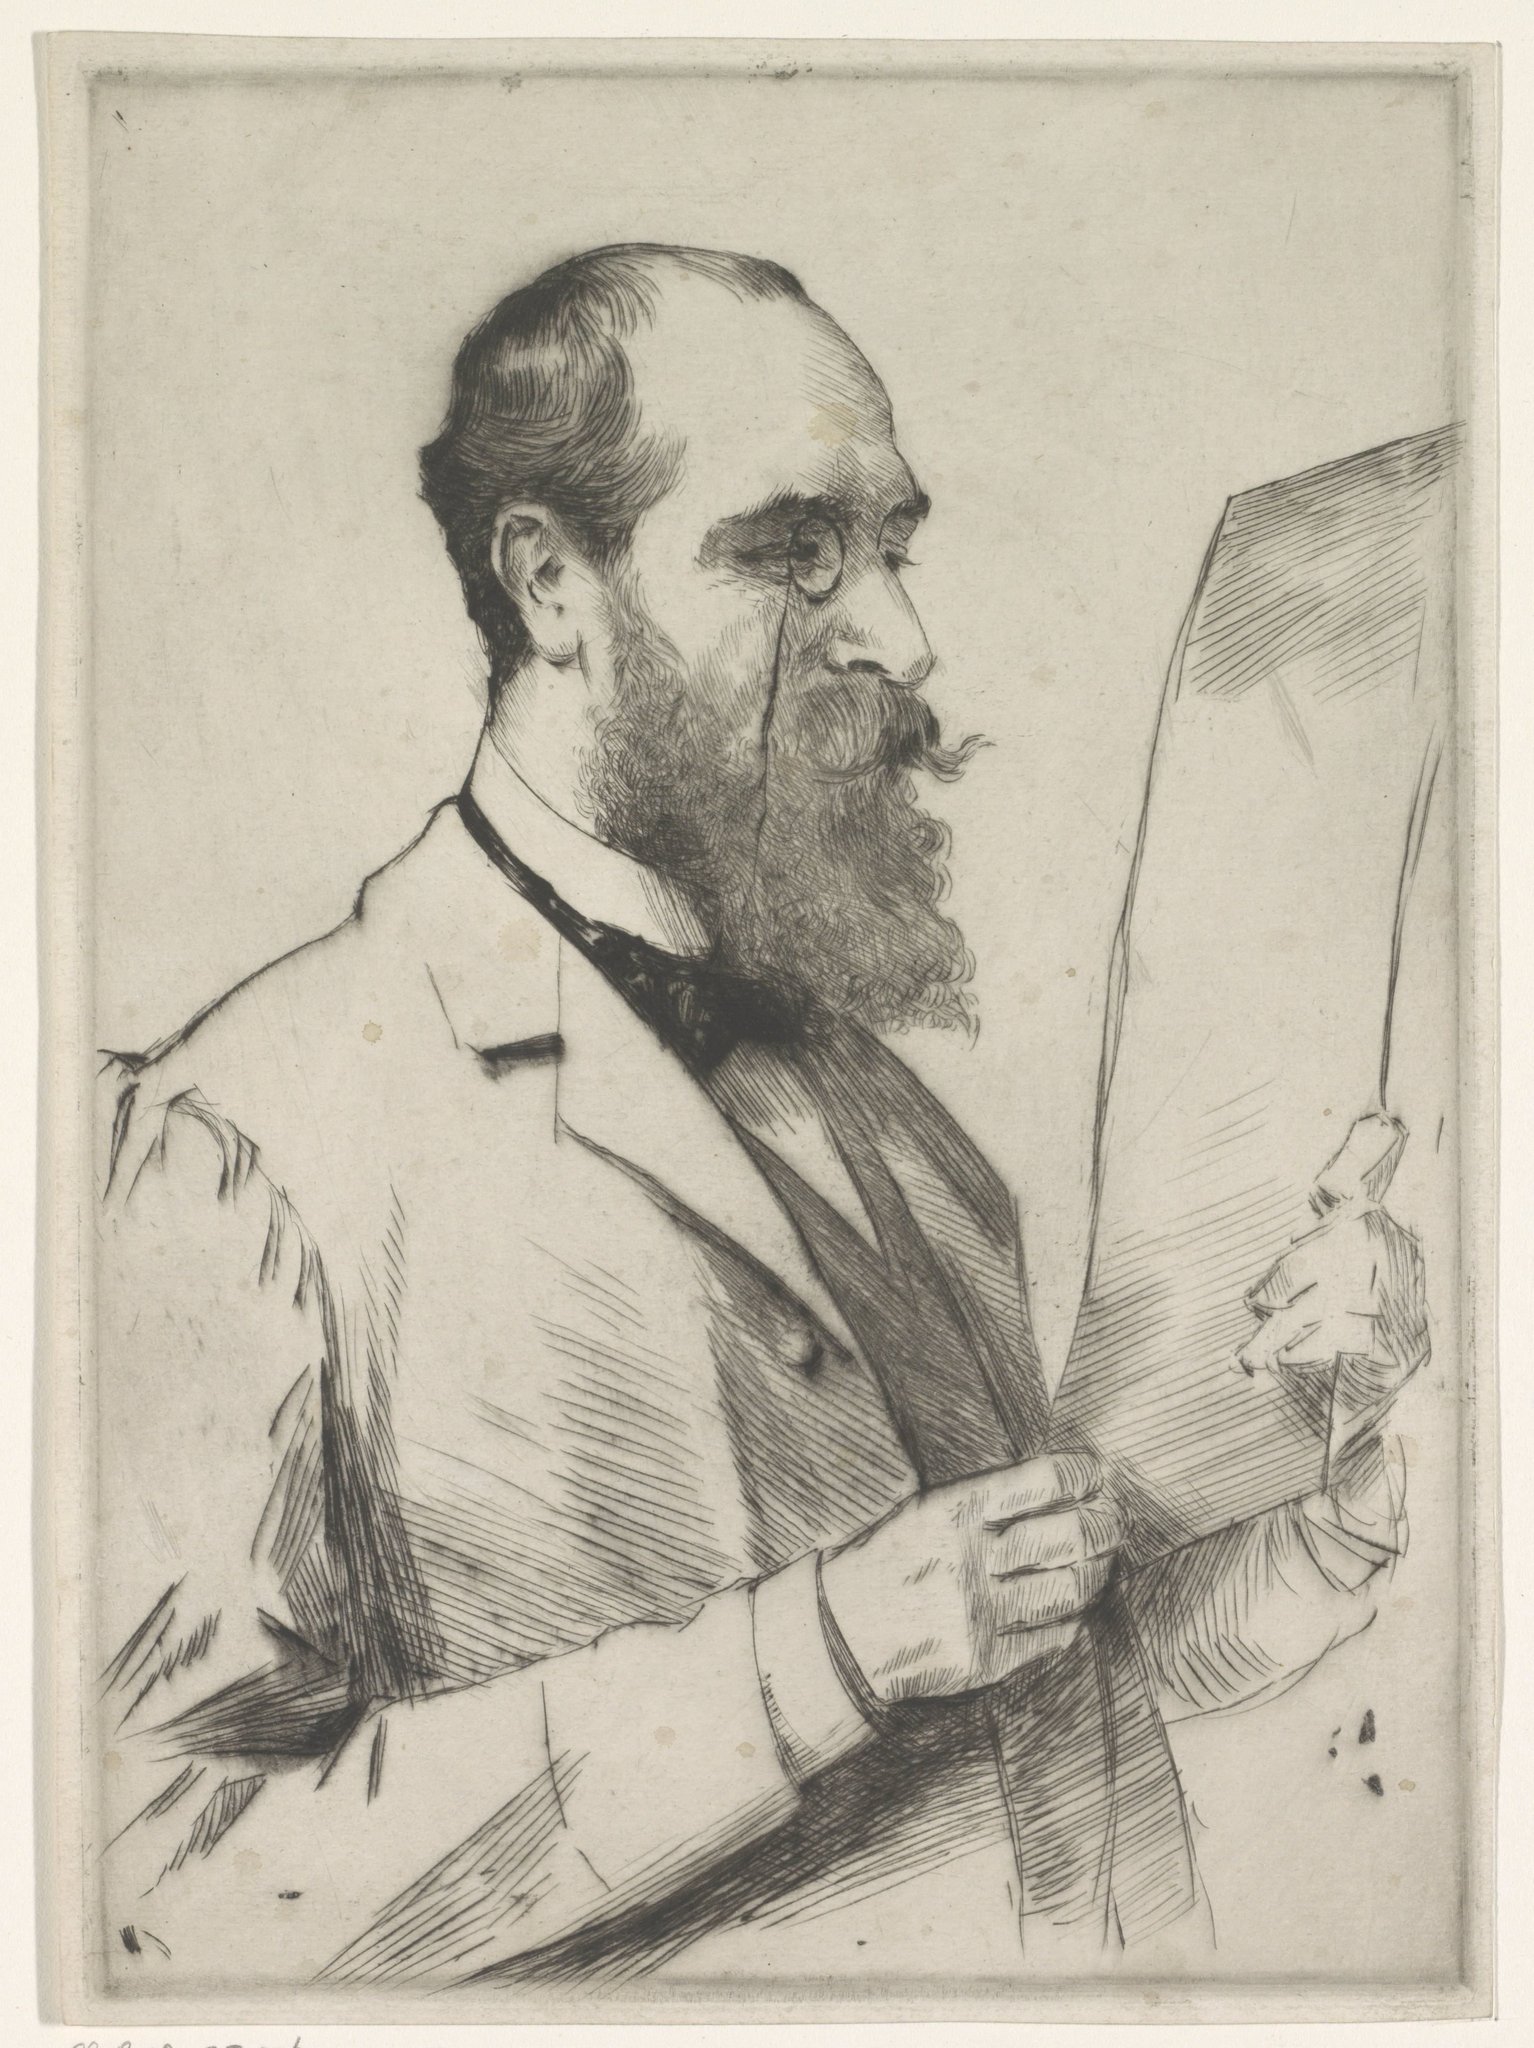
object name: print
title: Portret van een lezende man met monocle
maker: Anonymous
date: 1800-1900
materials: paper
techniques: drypoint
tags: reading, monocle, single lorgnette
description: Een man leest met een monocle voor zijn oog het papier dat hij in zijn handen houdt.